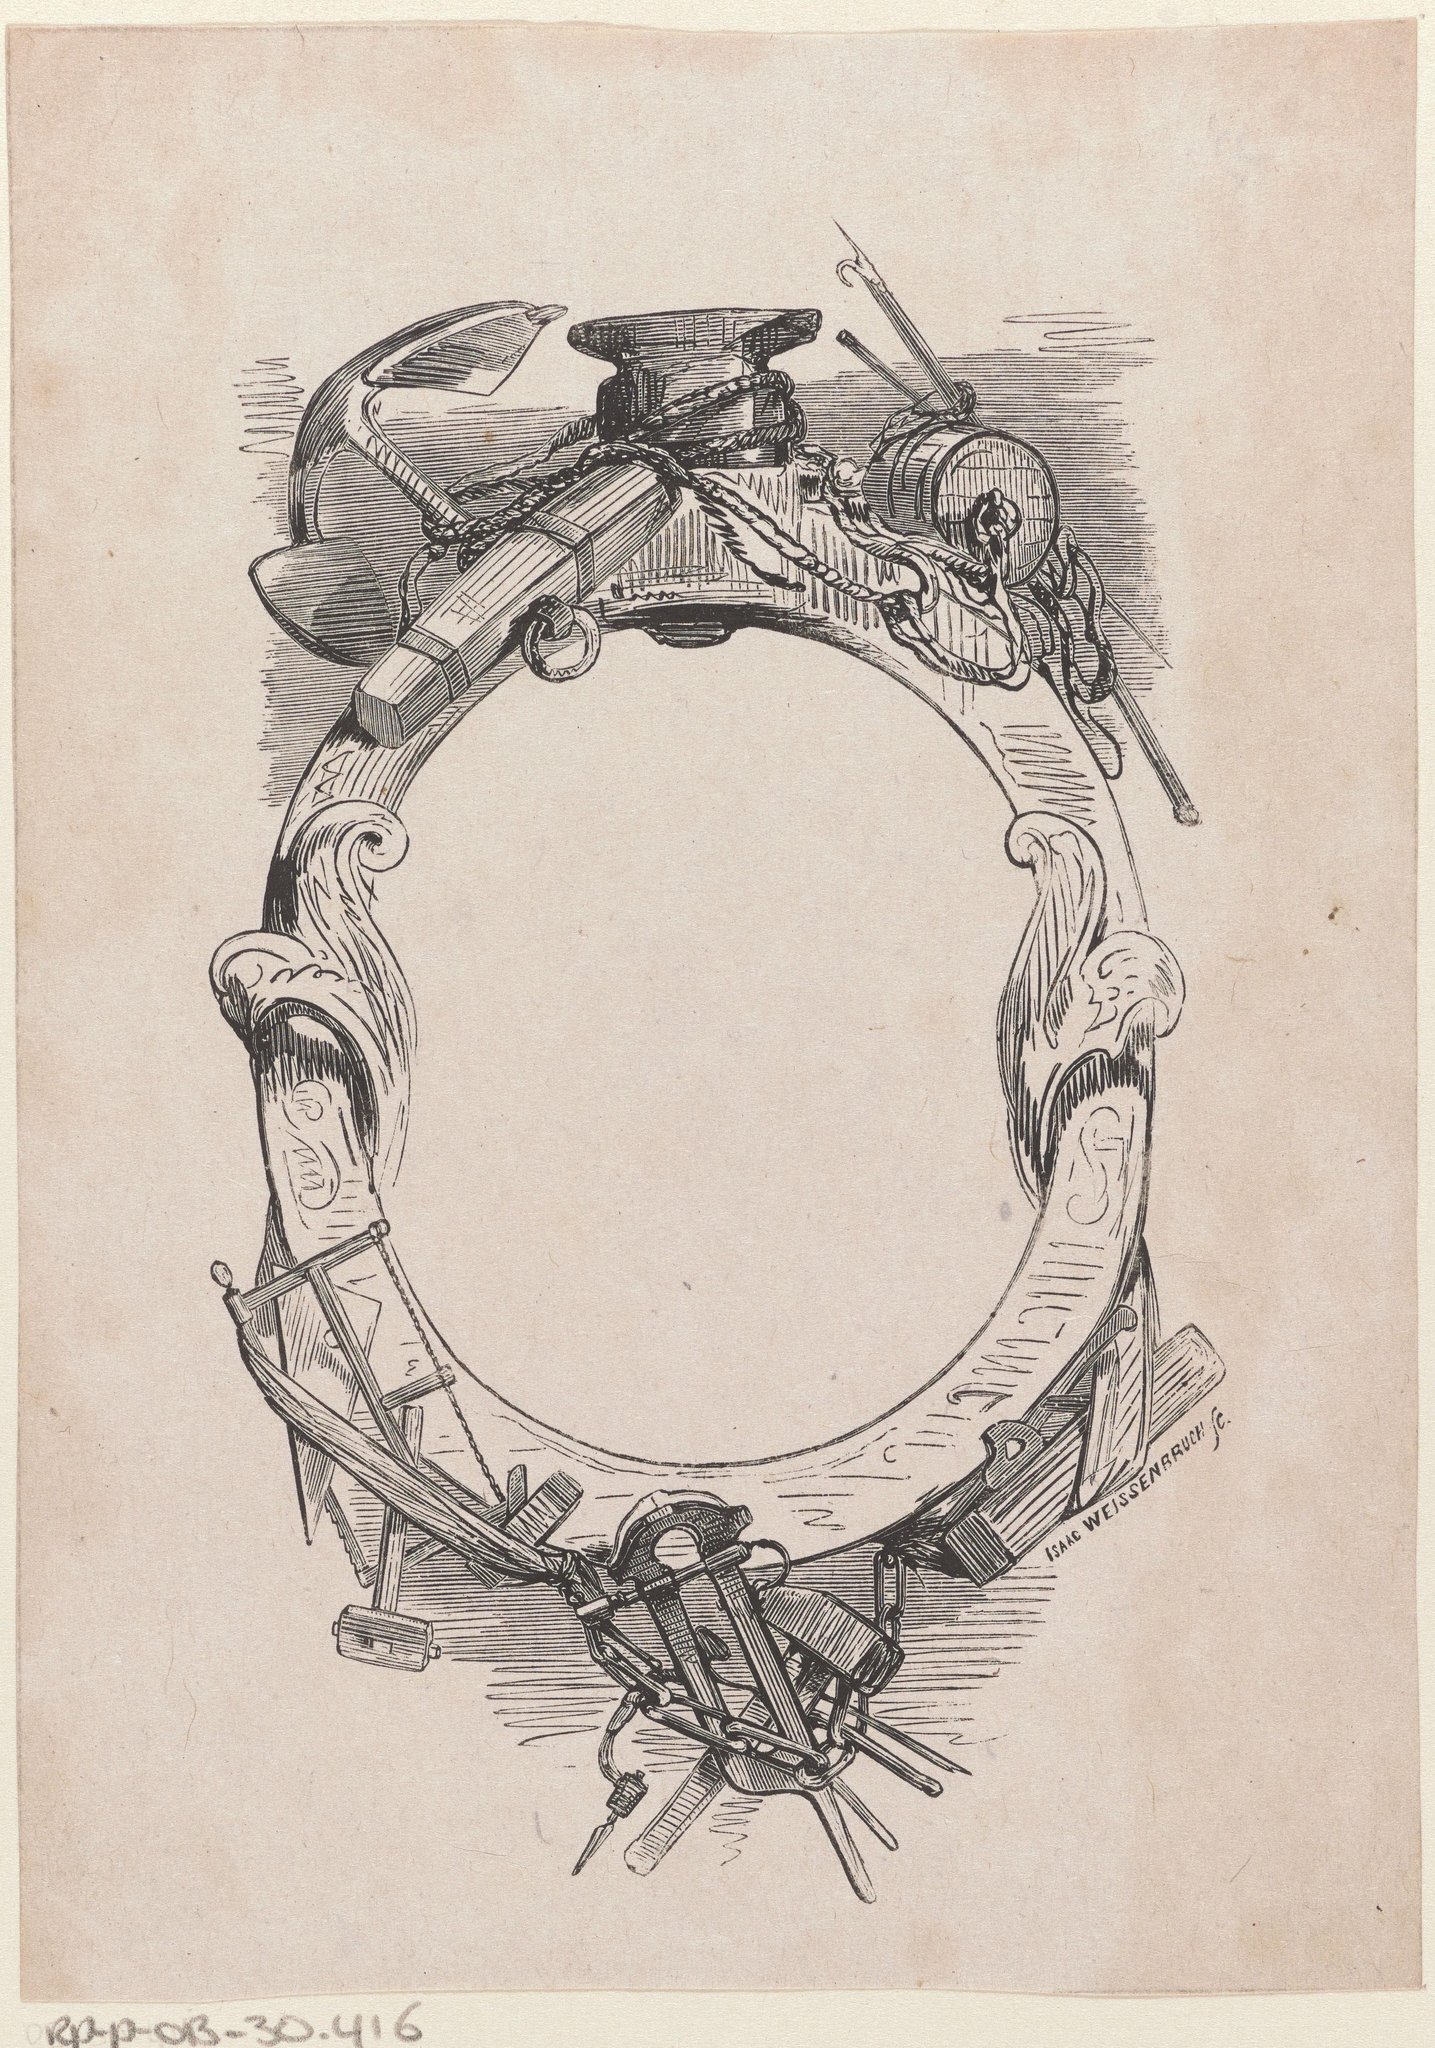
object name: print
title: Ovale omlijsting met objecten uit de scheepsbouw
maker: isaac weissenbruch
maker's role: print maker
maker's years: 1826-1912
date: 1836-1912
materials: paper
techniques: engraving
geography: netherlands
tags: tools, aids, implements ~ crafts and industries, shipbuilding industry